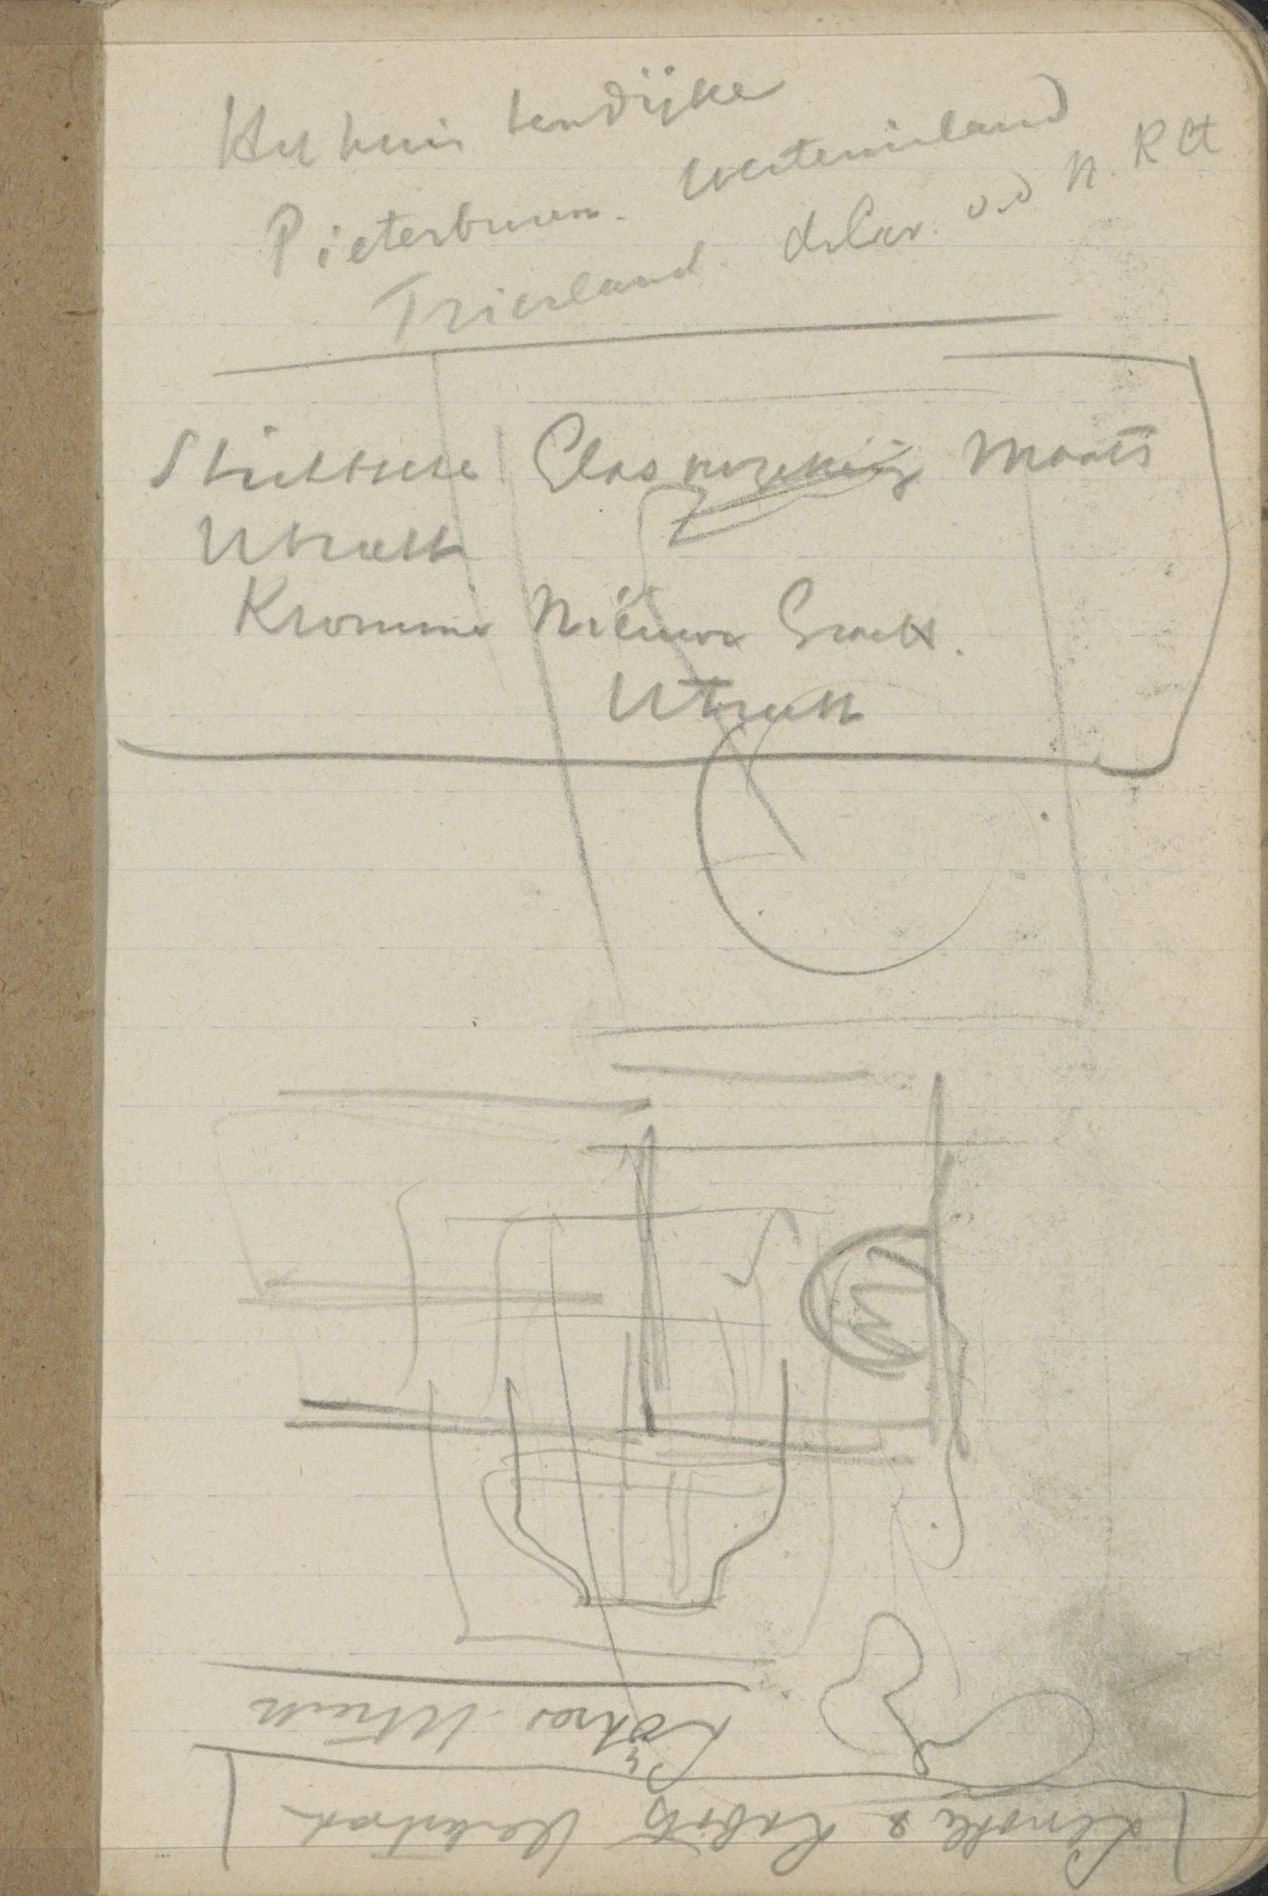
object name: sketchbook leaf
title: Studies en annotaties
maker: george hendrik breitner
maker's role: draughtsman, painter, print maker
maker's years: 1857-1923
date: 1903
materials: pencil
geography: amsterdam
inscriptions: annotation: ‘Het huis ten dijke/ Pieterburen [...]/ Stichtsche Glas[...]/ Utrecht/ Kromme Nieuwe Gracht/ Utrecht/ Lenoble &’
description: Pagina 4 uit een schetsboek met 32 bladen.